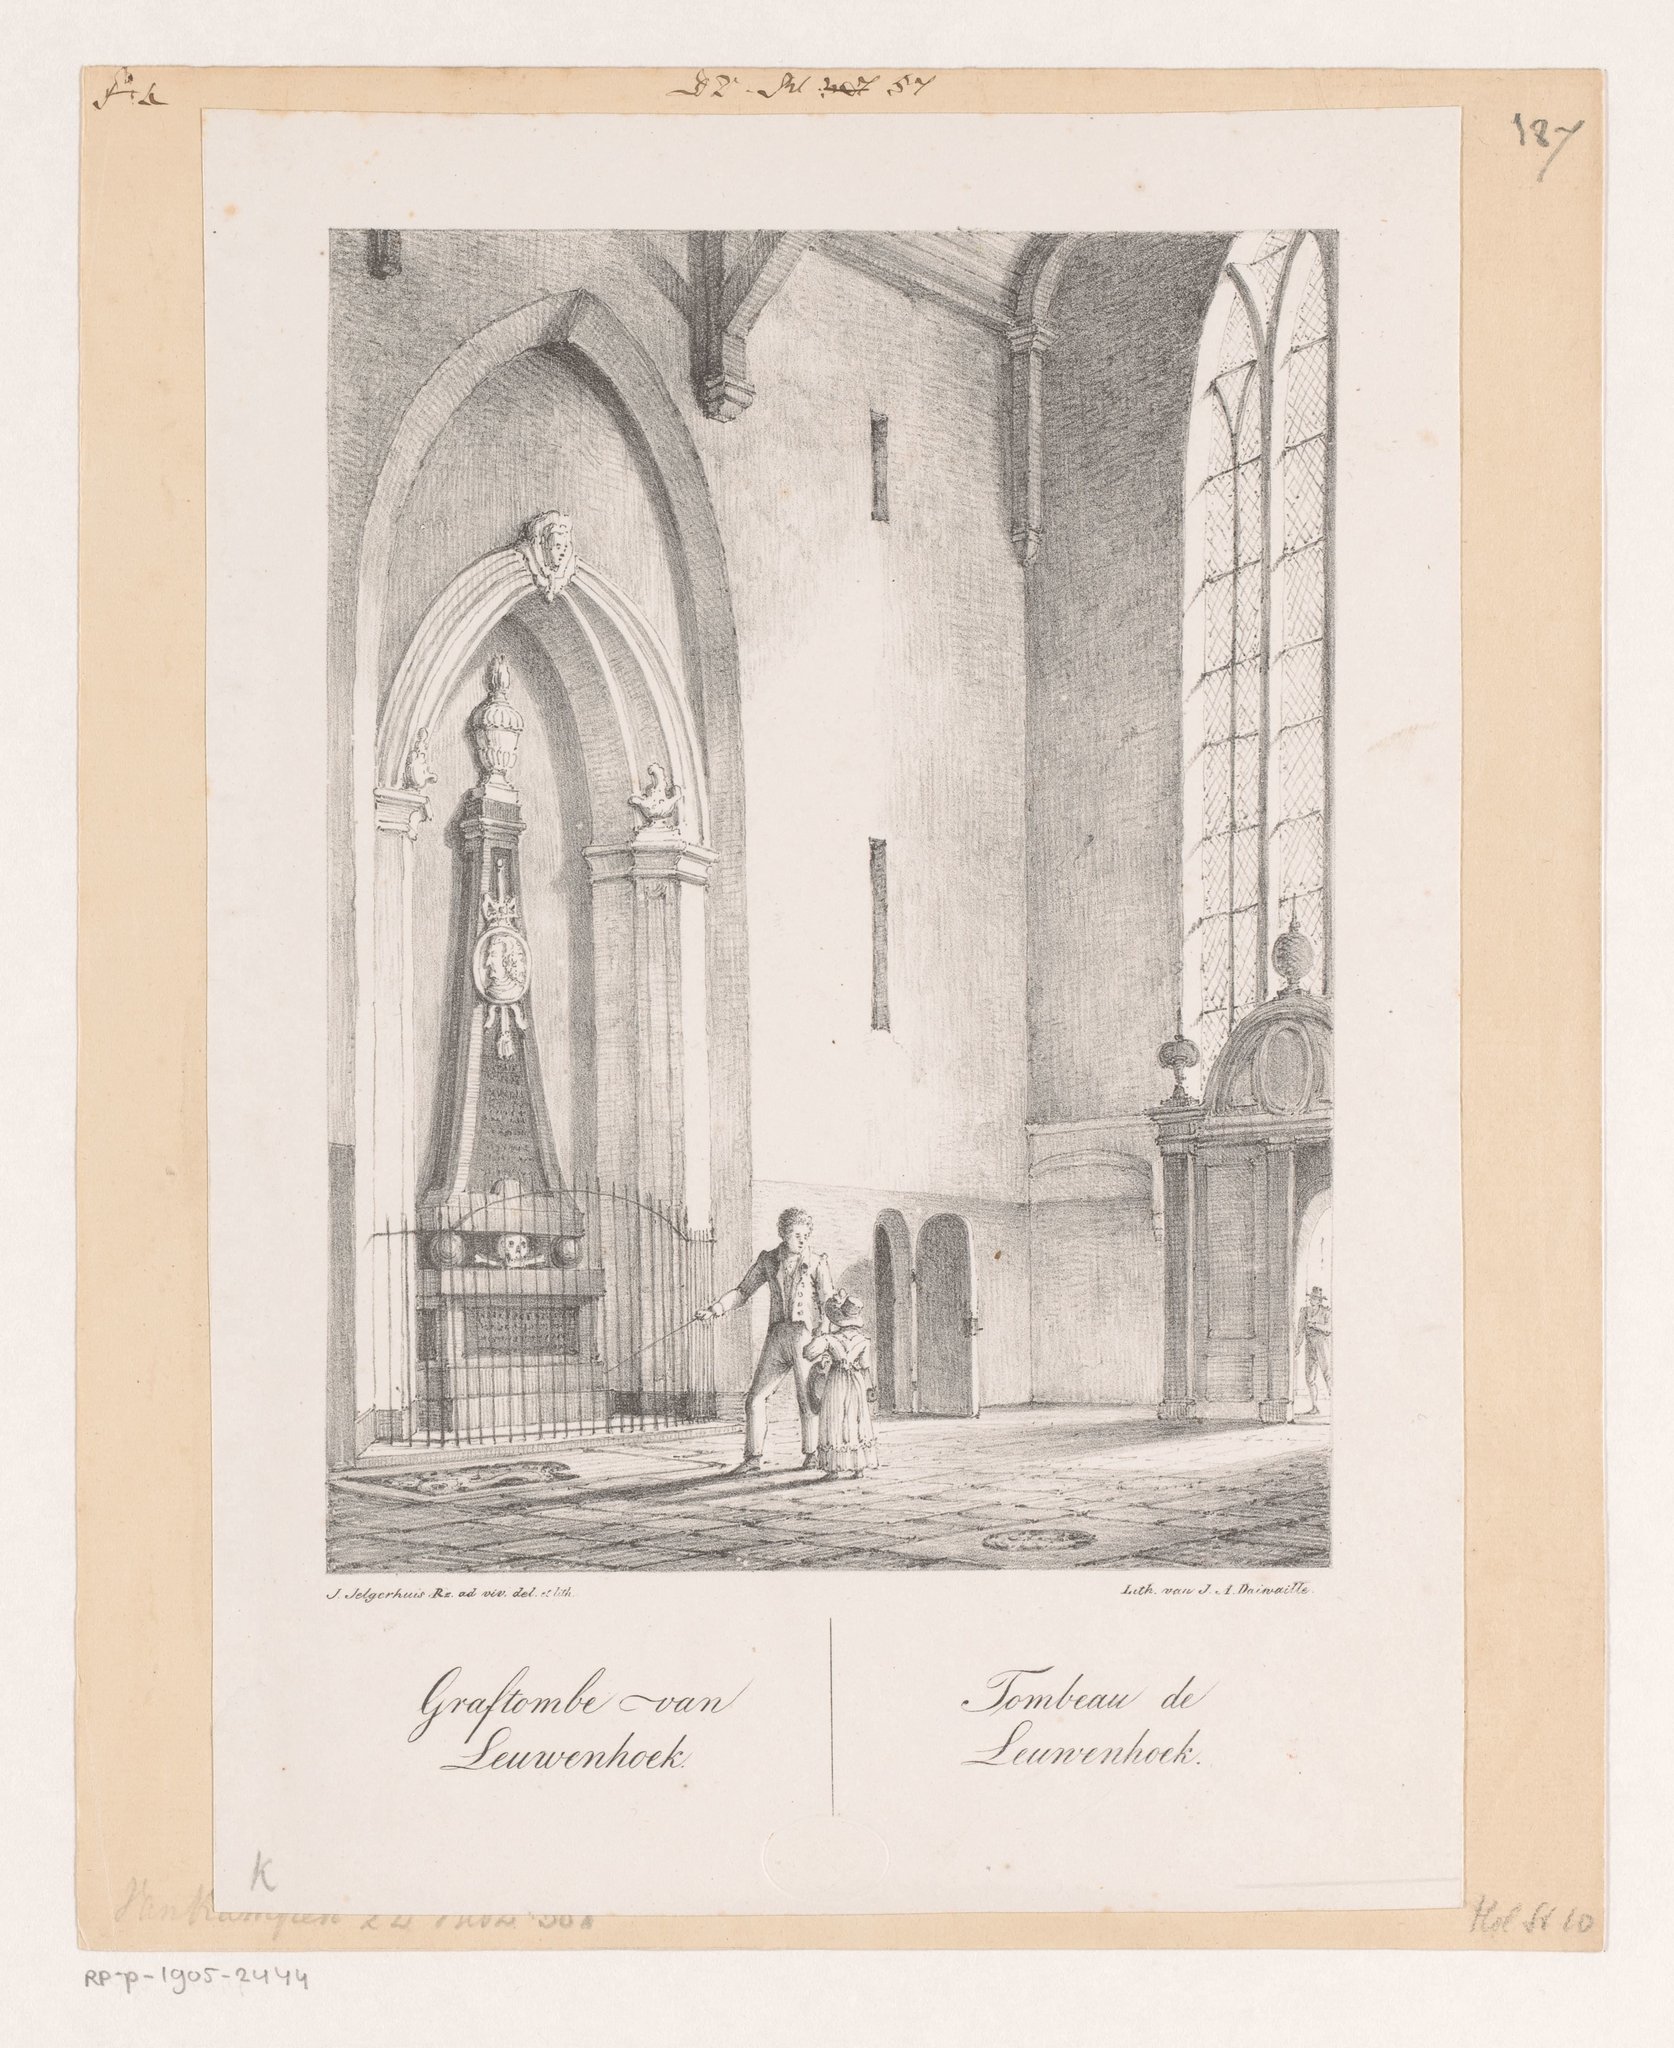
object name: print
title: Graftome van Antoni van Leeuwenhoek in de Oude Kerk in Delft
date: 1829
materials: paper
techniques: lithograph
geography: delft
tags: delft, anthony van leeuwenhoek, grave, tomb, interior of church, needle, obelisk (marking grave)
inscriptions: inscription: ‘Van Kampen 2 Be Blz 307’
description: Twee figuren staan bij het graf, de man wijst ernaar. Tegen de wand een grafmonument bestaande uit een obelisk met een portret van Van Leeuwenhoek.